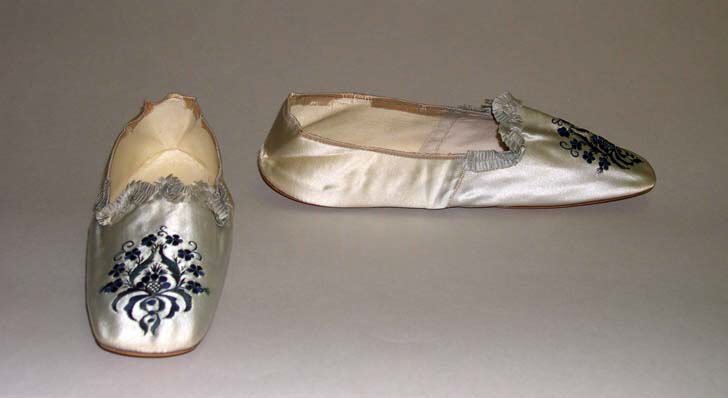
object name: slipper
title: Slippers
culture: american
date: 1840-1849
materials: leather, silk